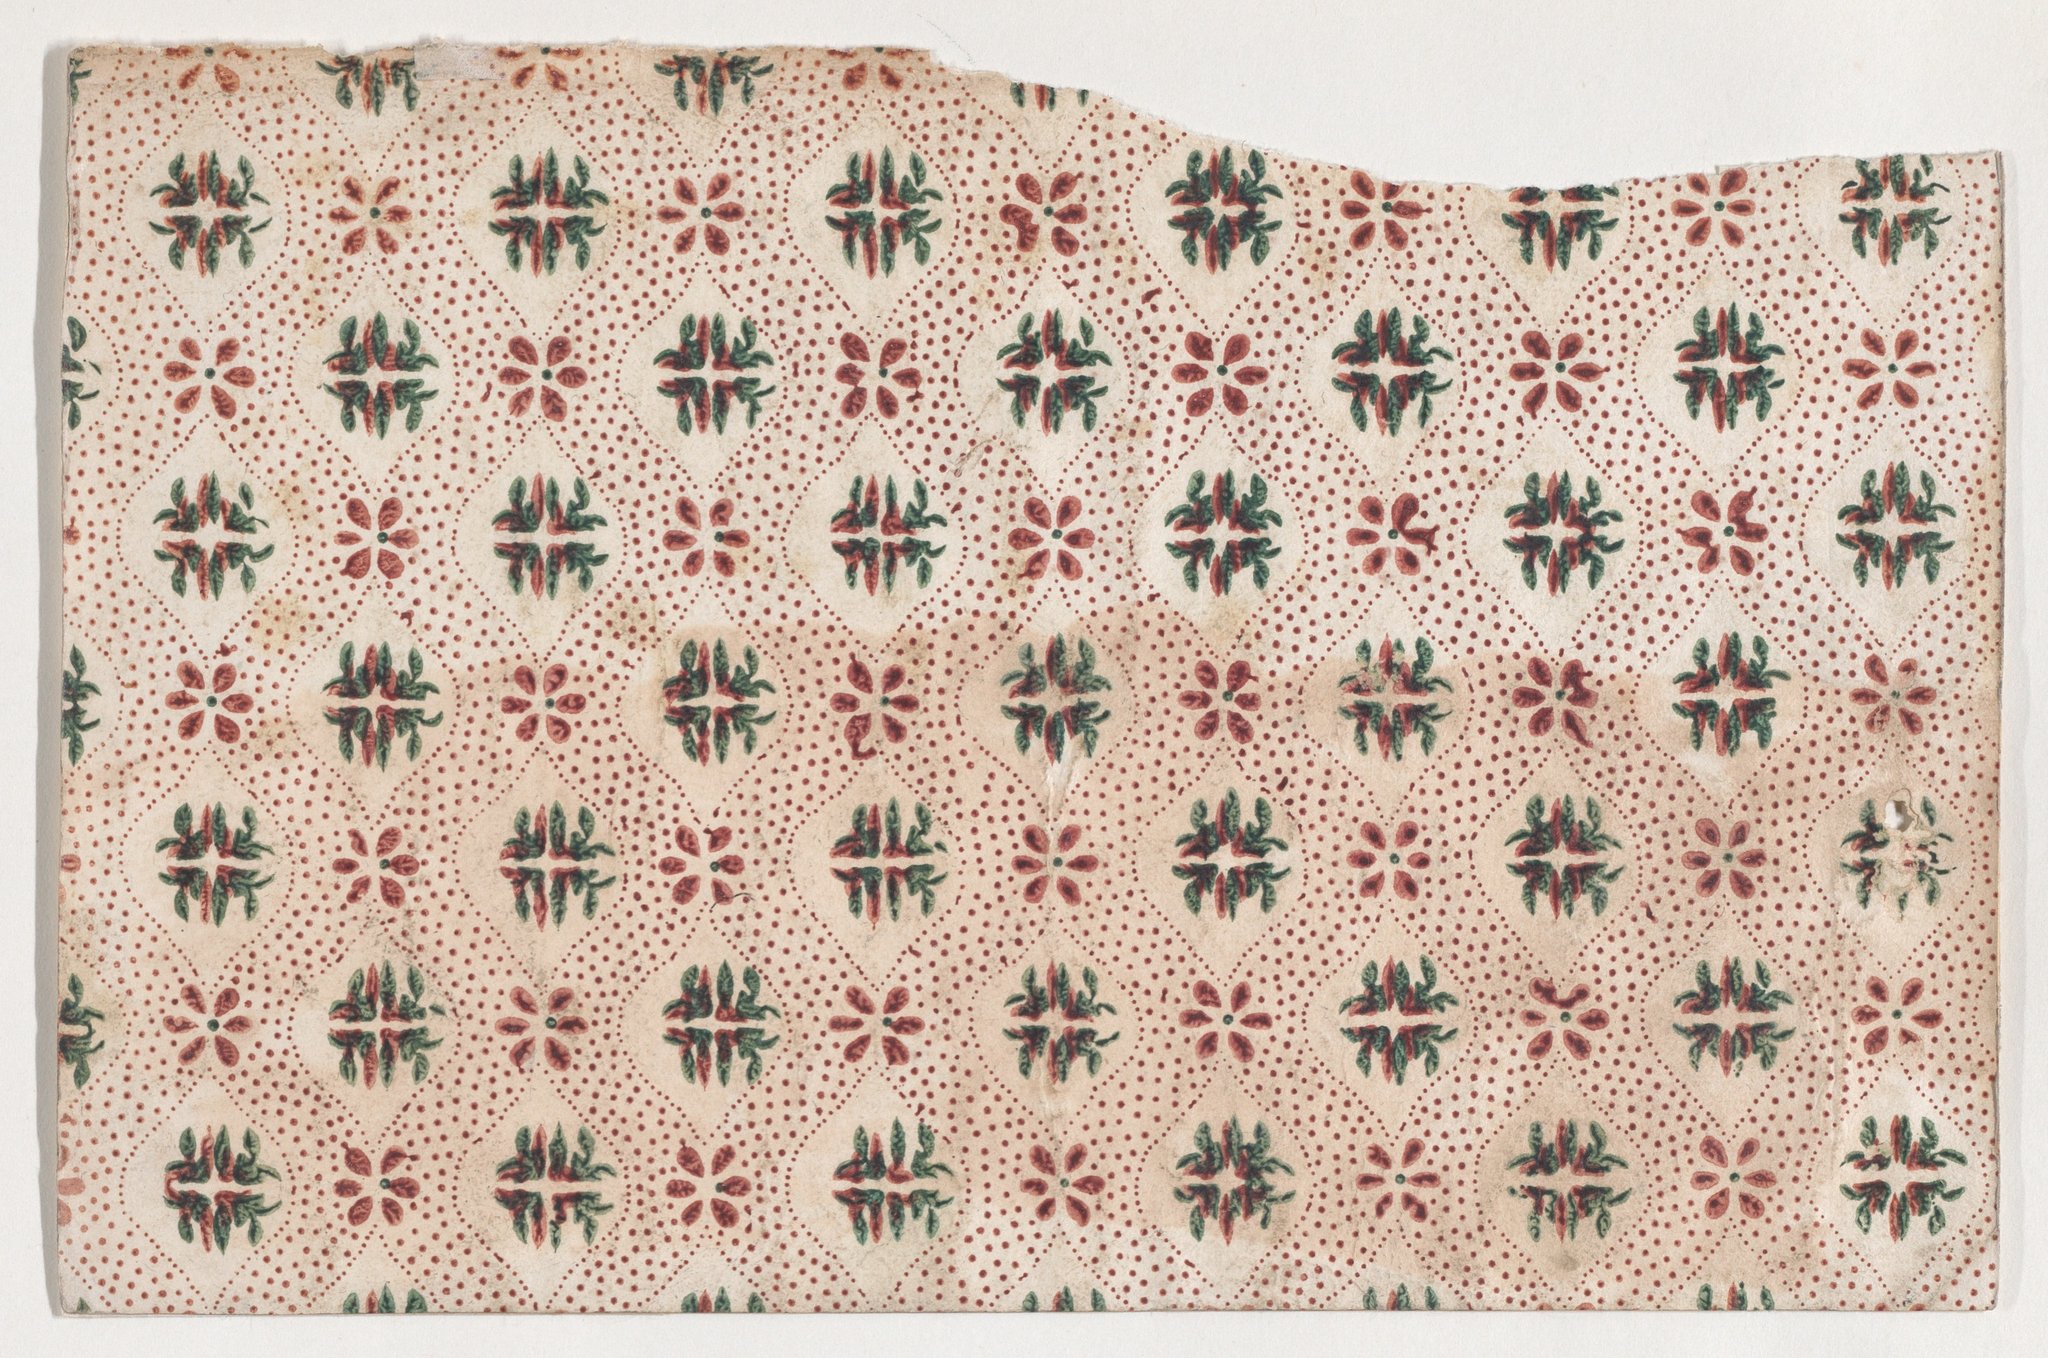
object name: print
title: Sheet with overall floral and dot pattern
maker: Anonymous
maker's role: artist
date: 1801-1900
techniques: relief print